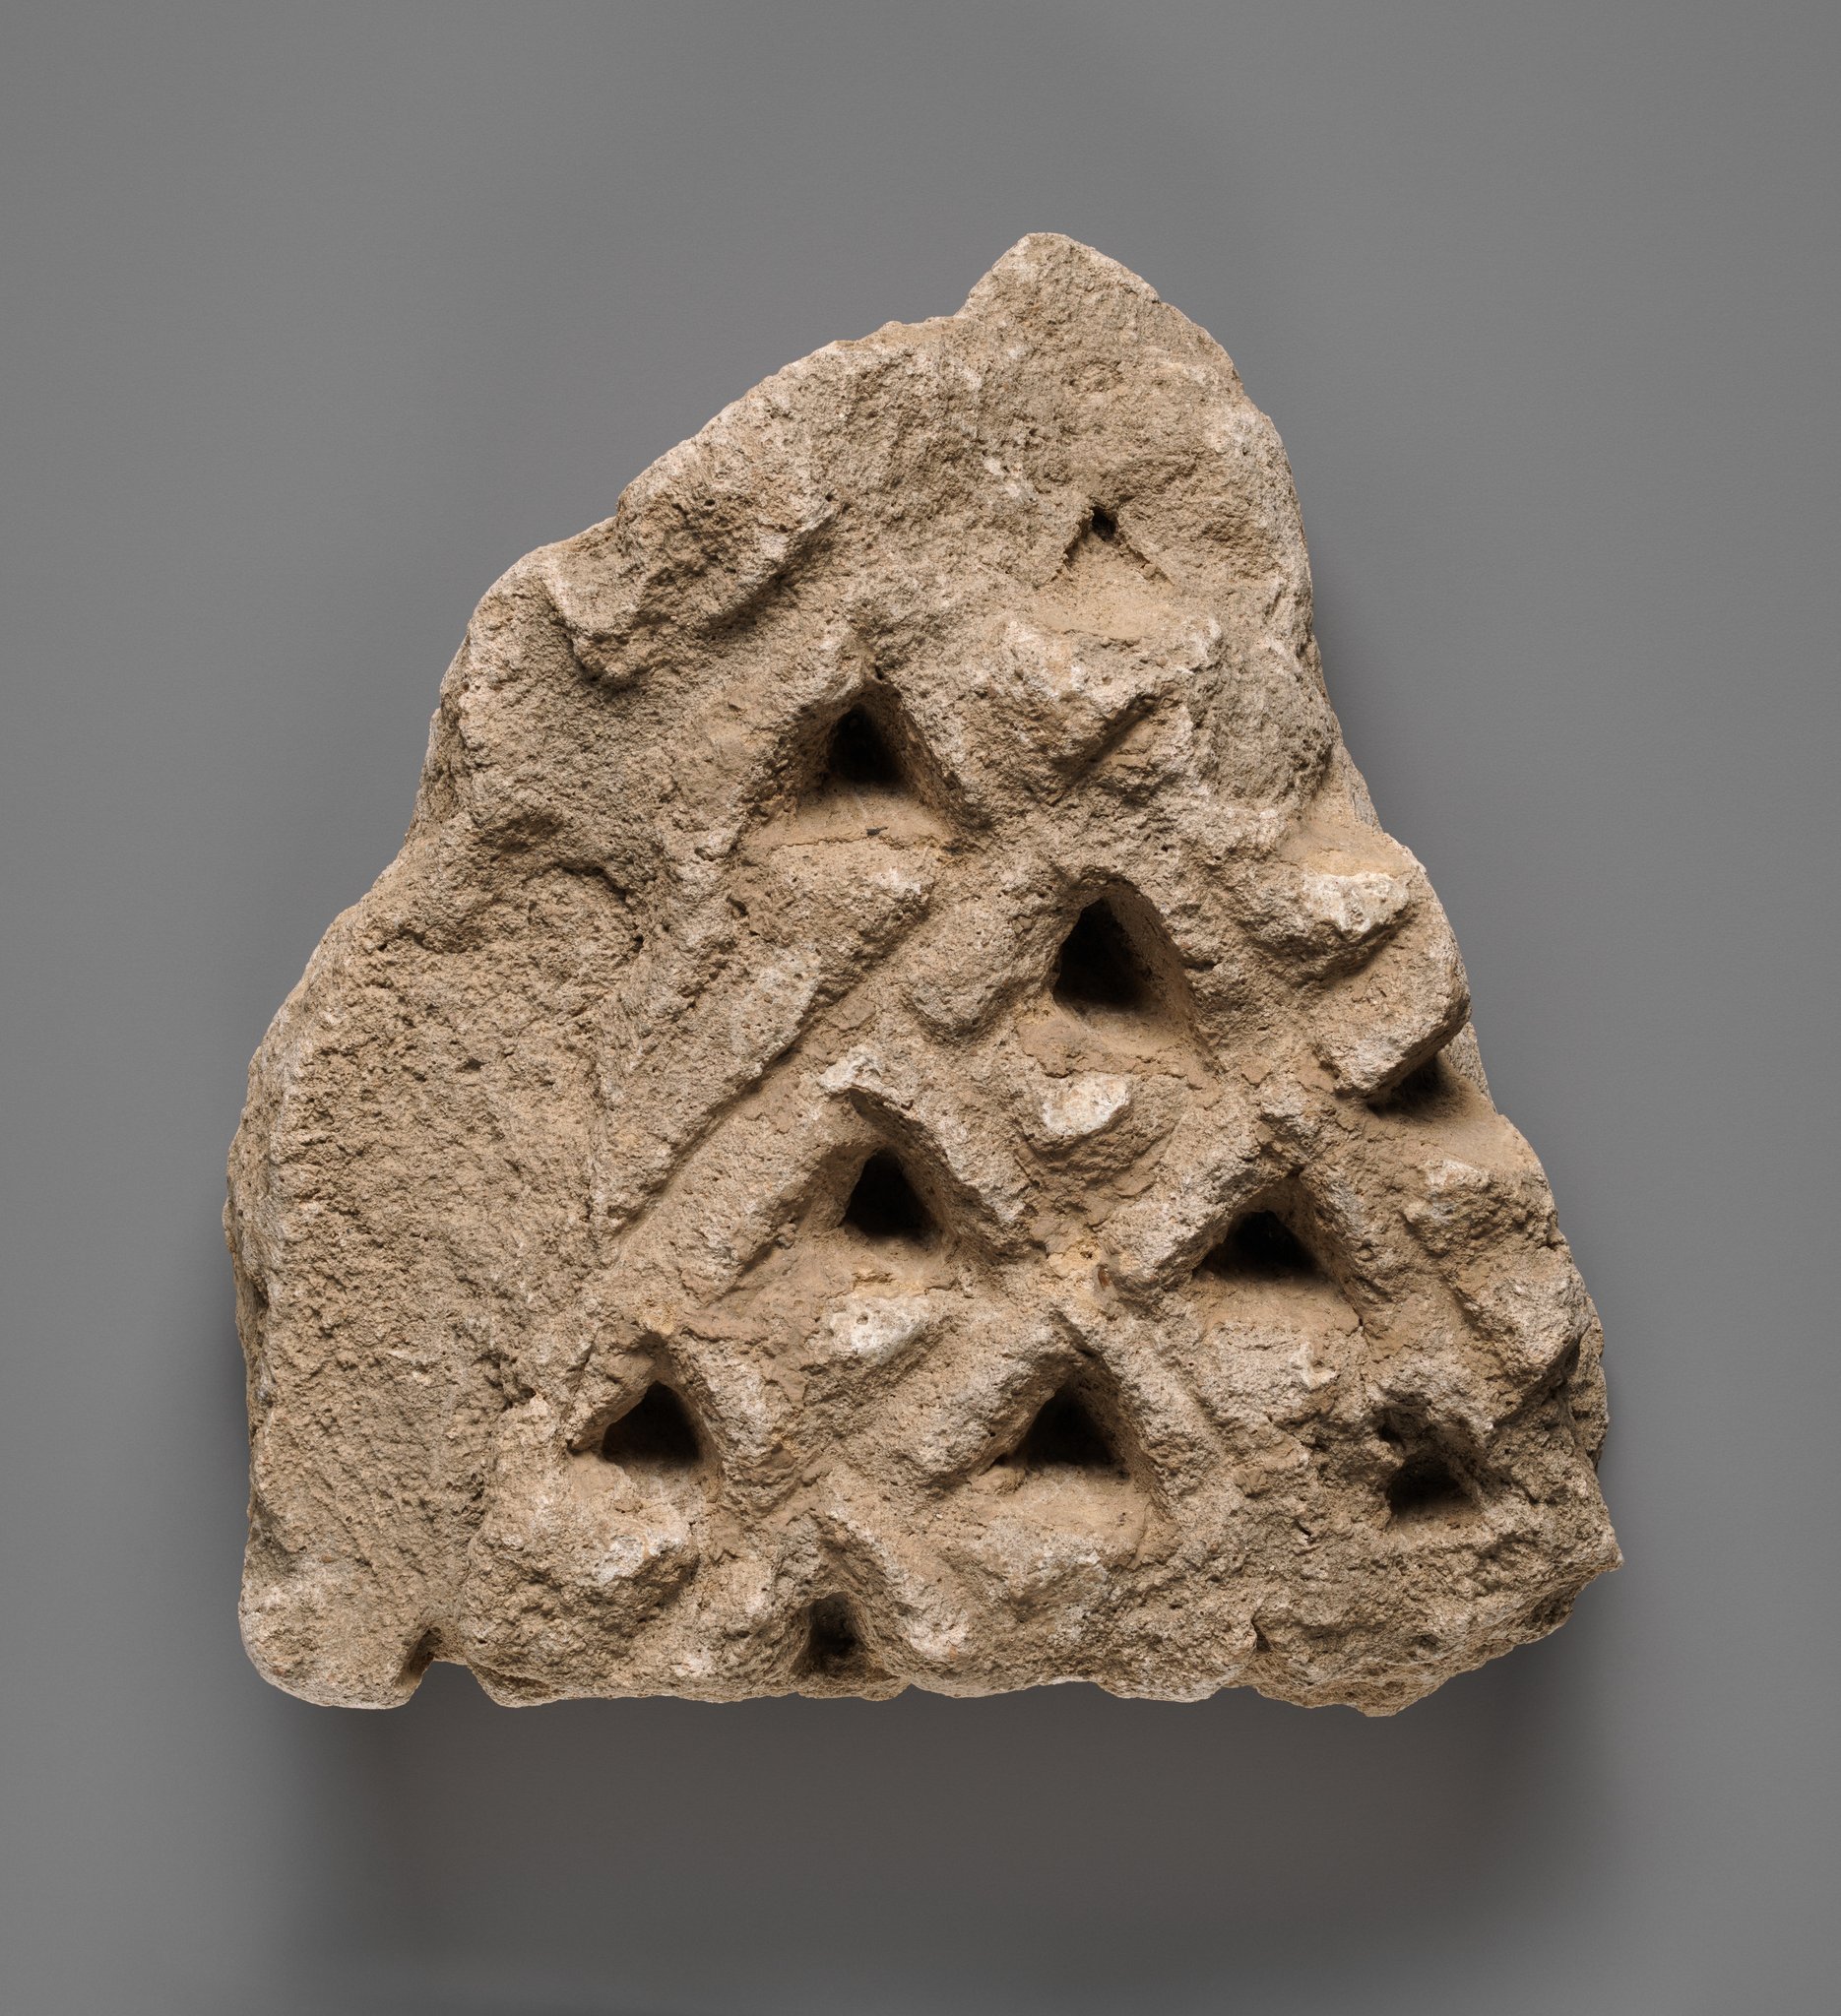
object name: relief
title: Relief fragment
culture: sasanian or islamic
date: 501-800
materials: plaster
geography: mesopotamia